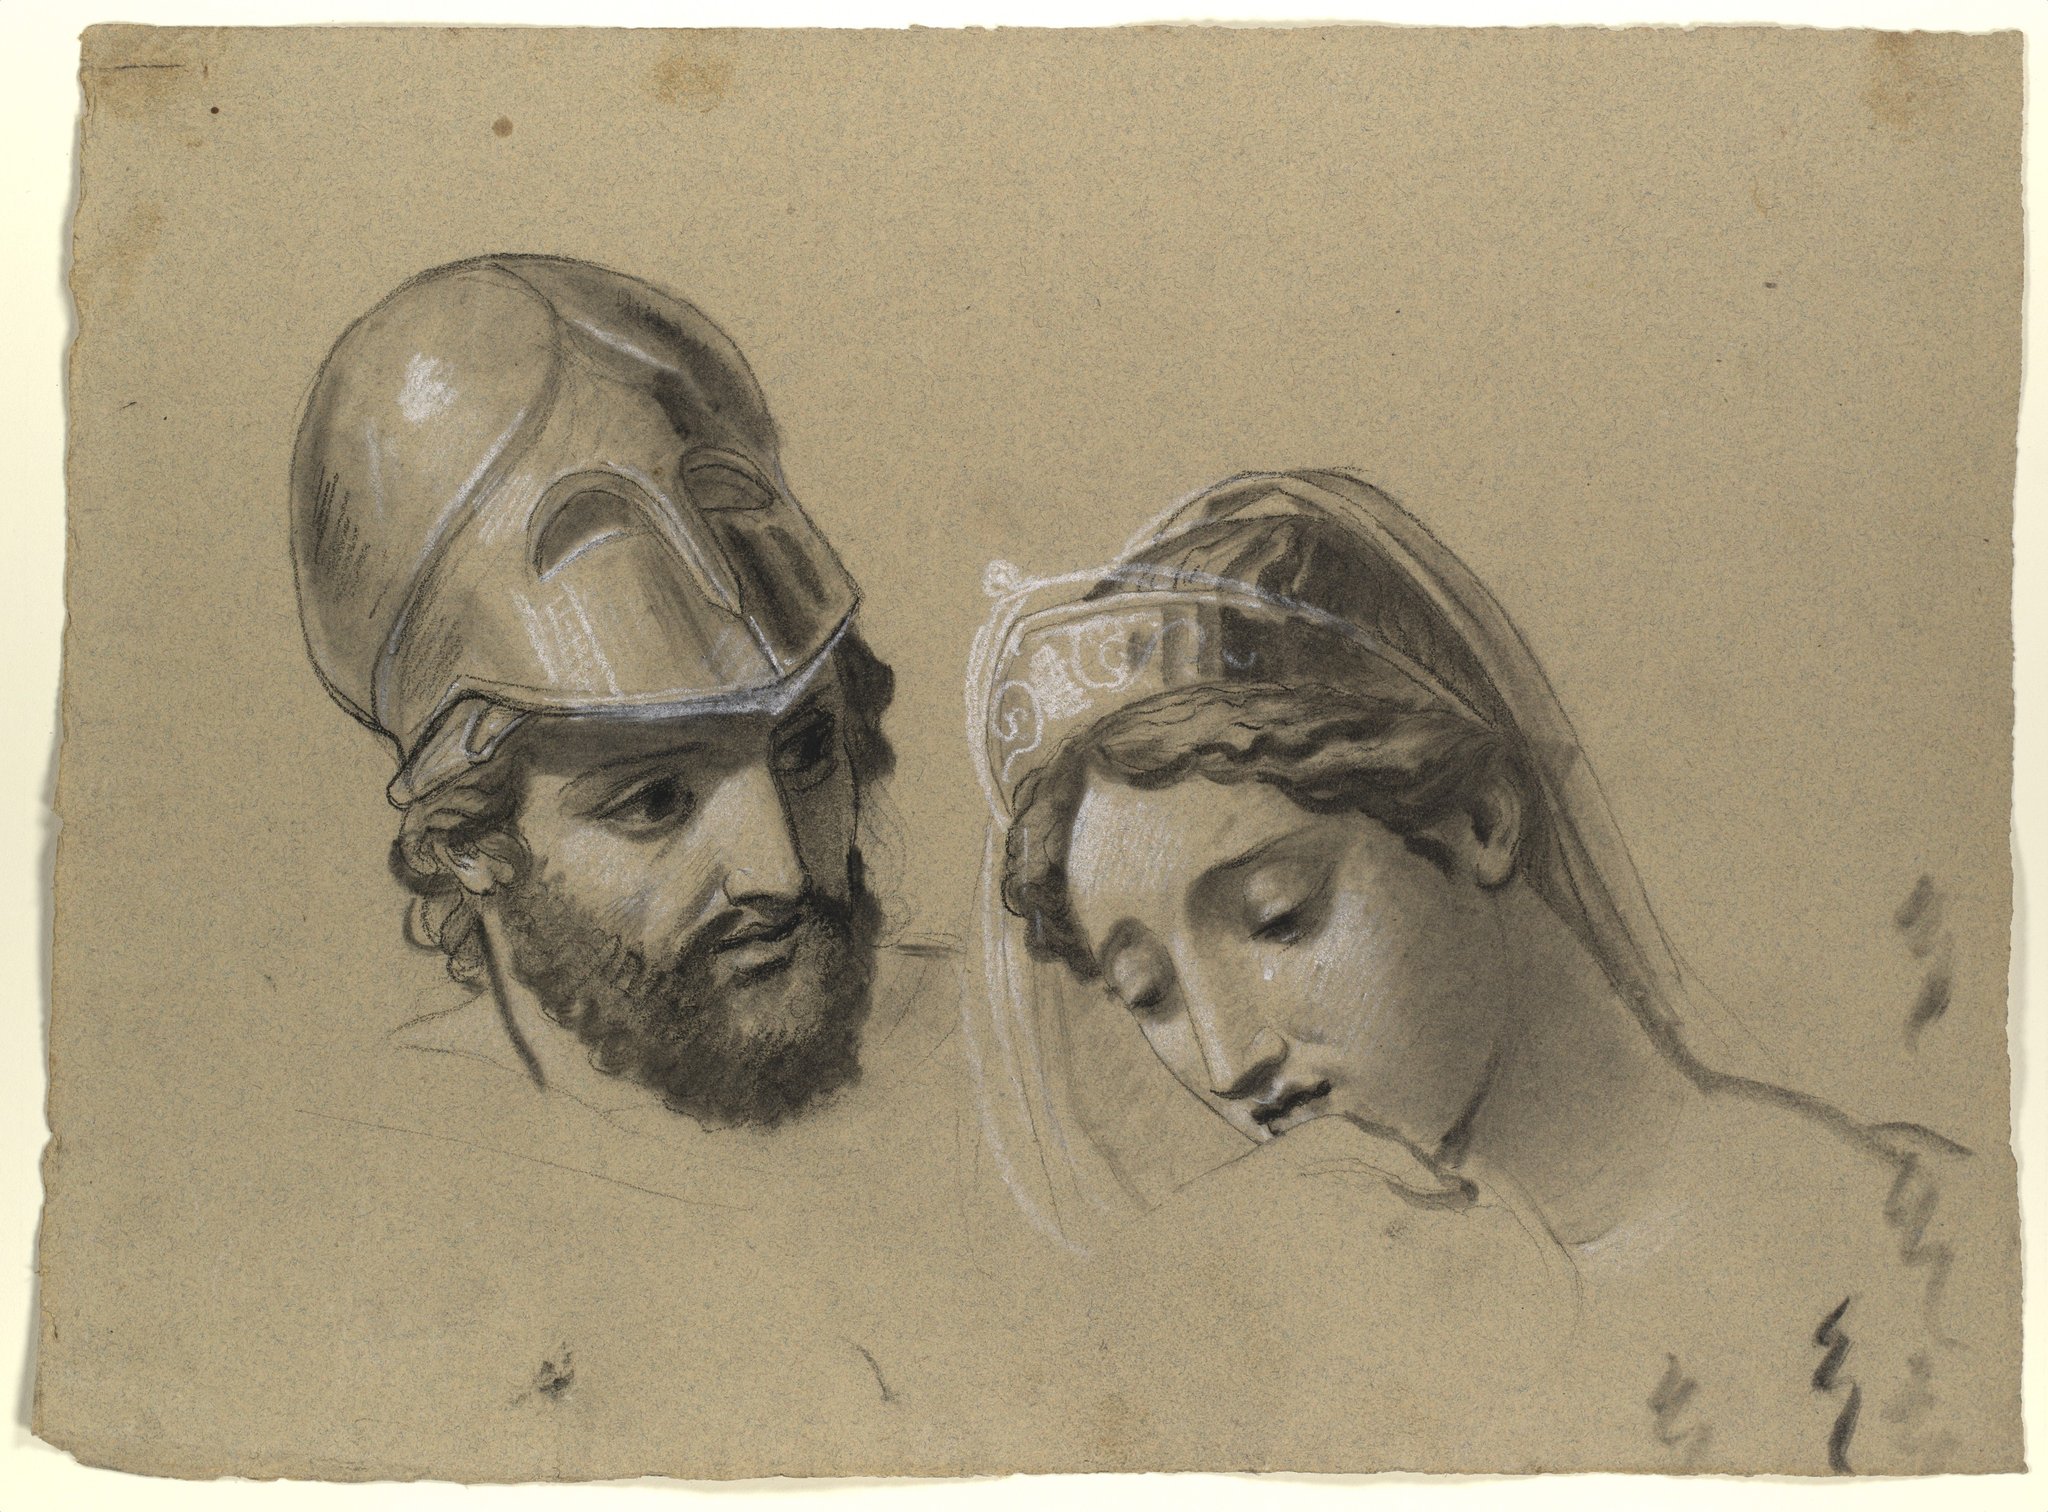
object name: drawing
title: Heads Studies for "Castor and Pollux Freeing Helen"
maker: joseph-ferdinand lancrenon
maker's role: artist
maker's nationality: french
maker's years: 1794-1874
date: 1817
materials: chalk, crayon, paper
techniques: stumping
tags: men,women